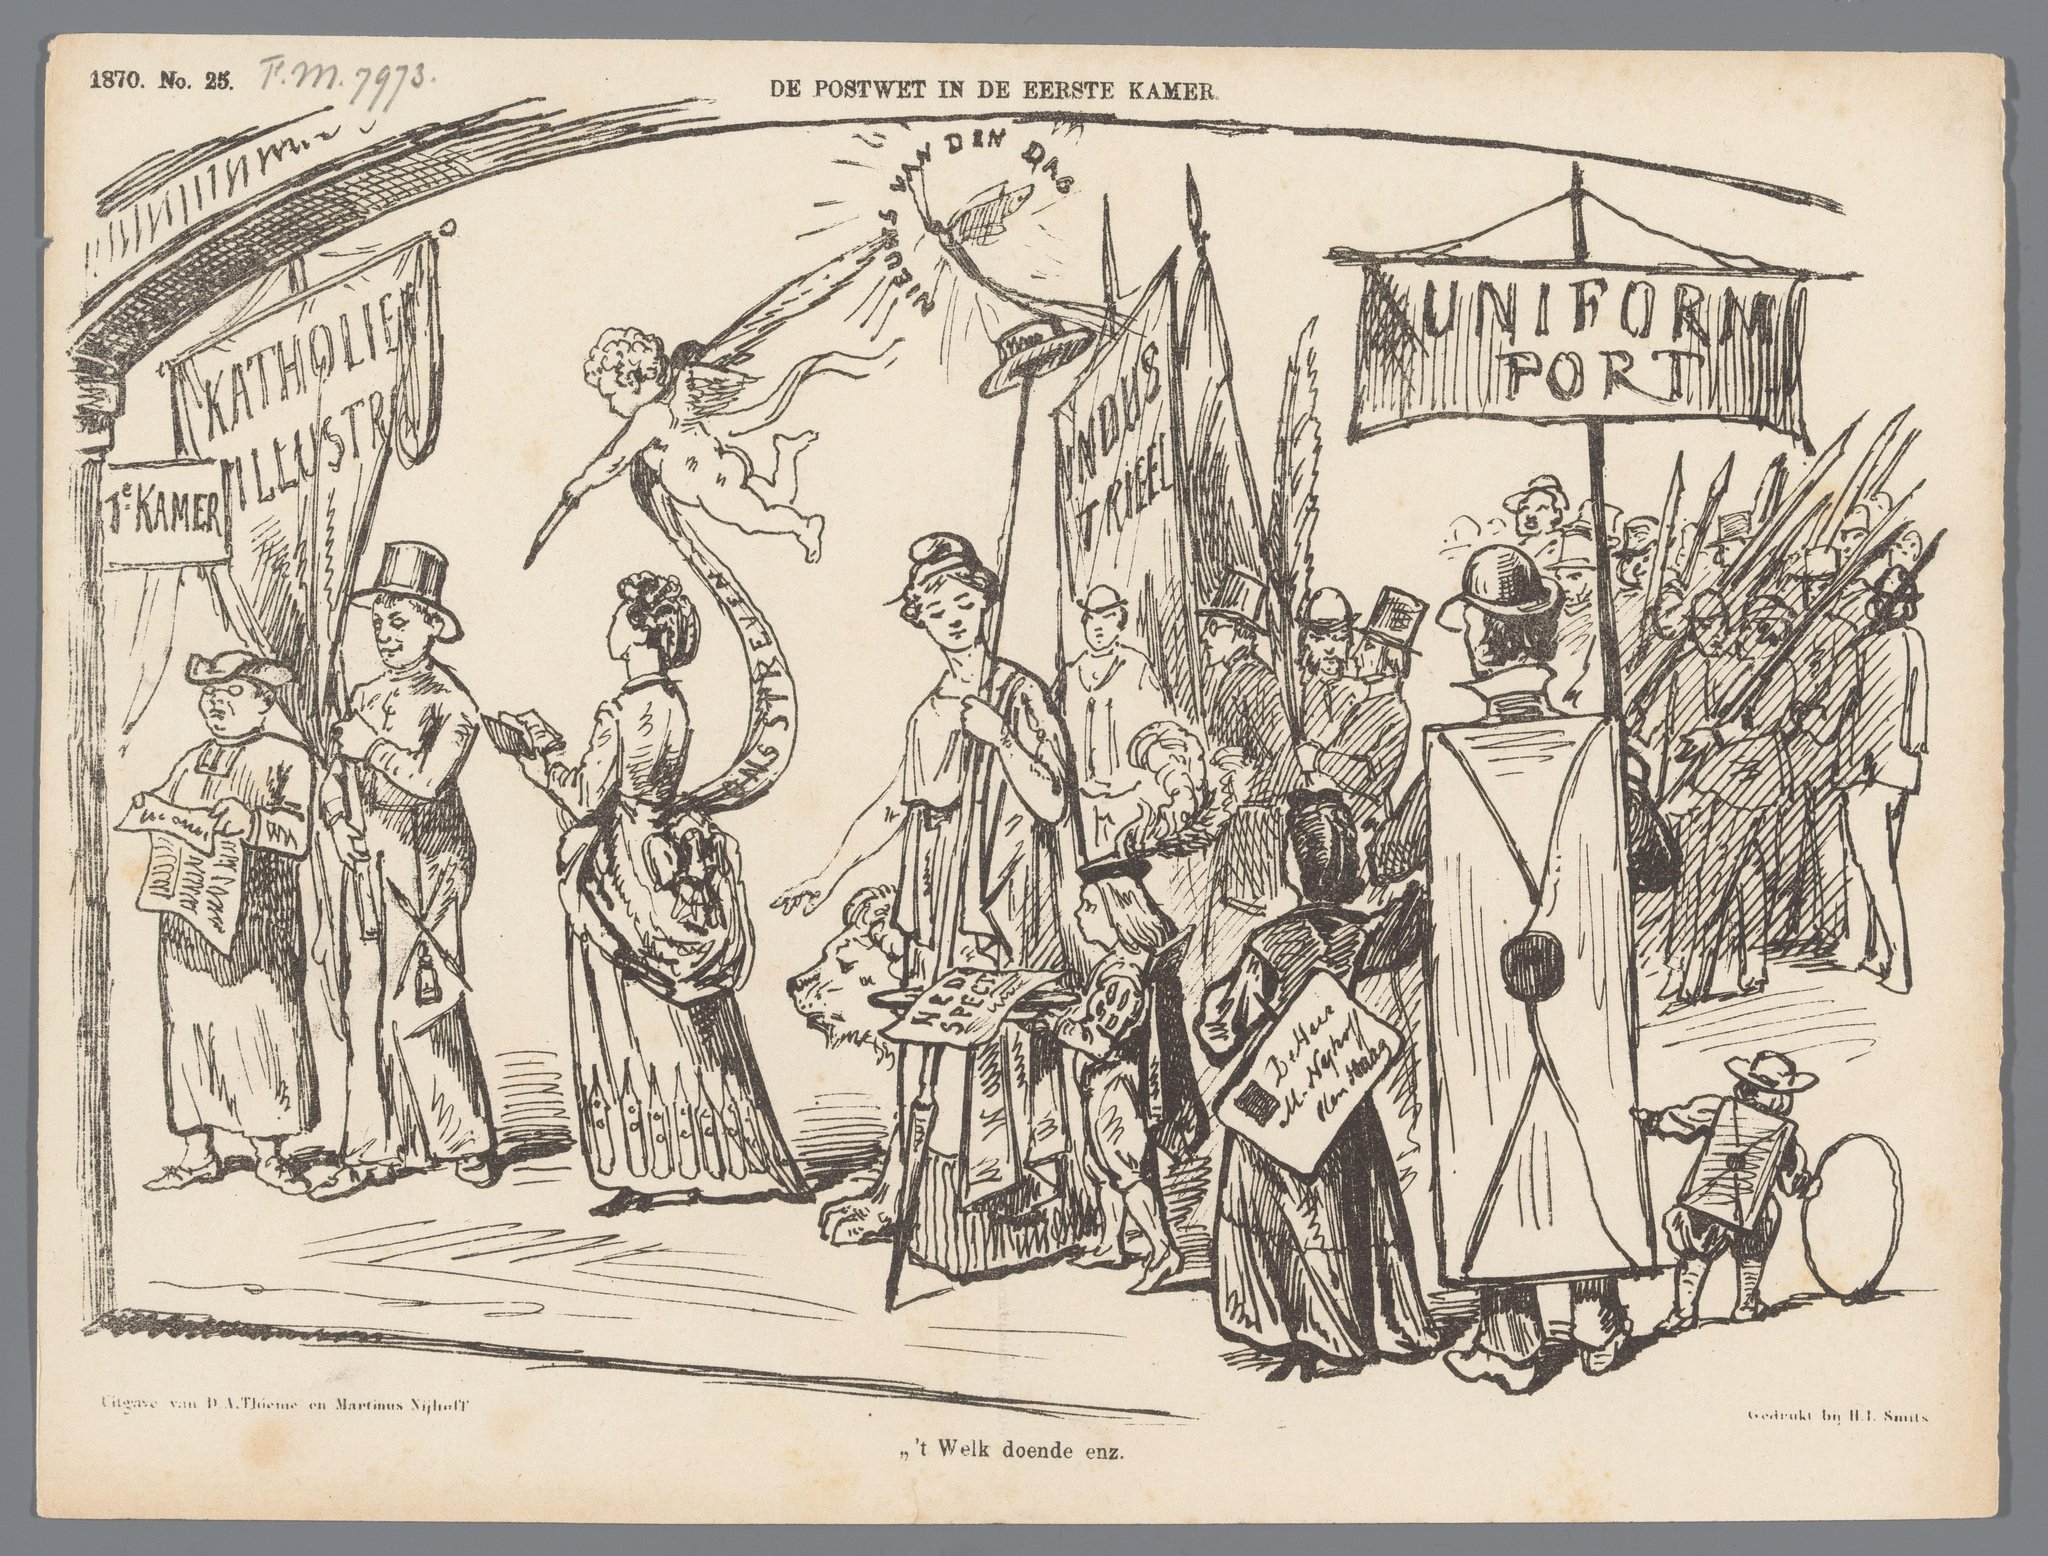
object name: print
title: De Postwet in de Eerste Kamer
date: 1870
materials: paper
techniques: lithograph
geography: netherlands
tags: newspaper, news-sheet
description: Spotprent op de behandeling van de postwet in de Eerste Kamer. De redacties van allerlei dagbladen vragen om goedkeuring van de postwet. Plaat verschenen bij het weekblad De Nederlandsche Spectator, nr. 25, 1870.